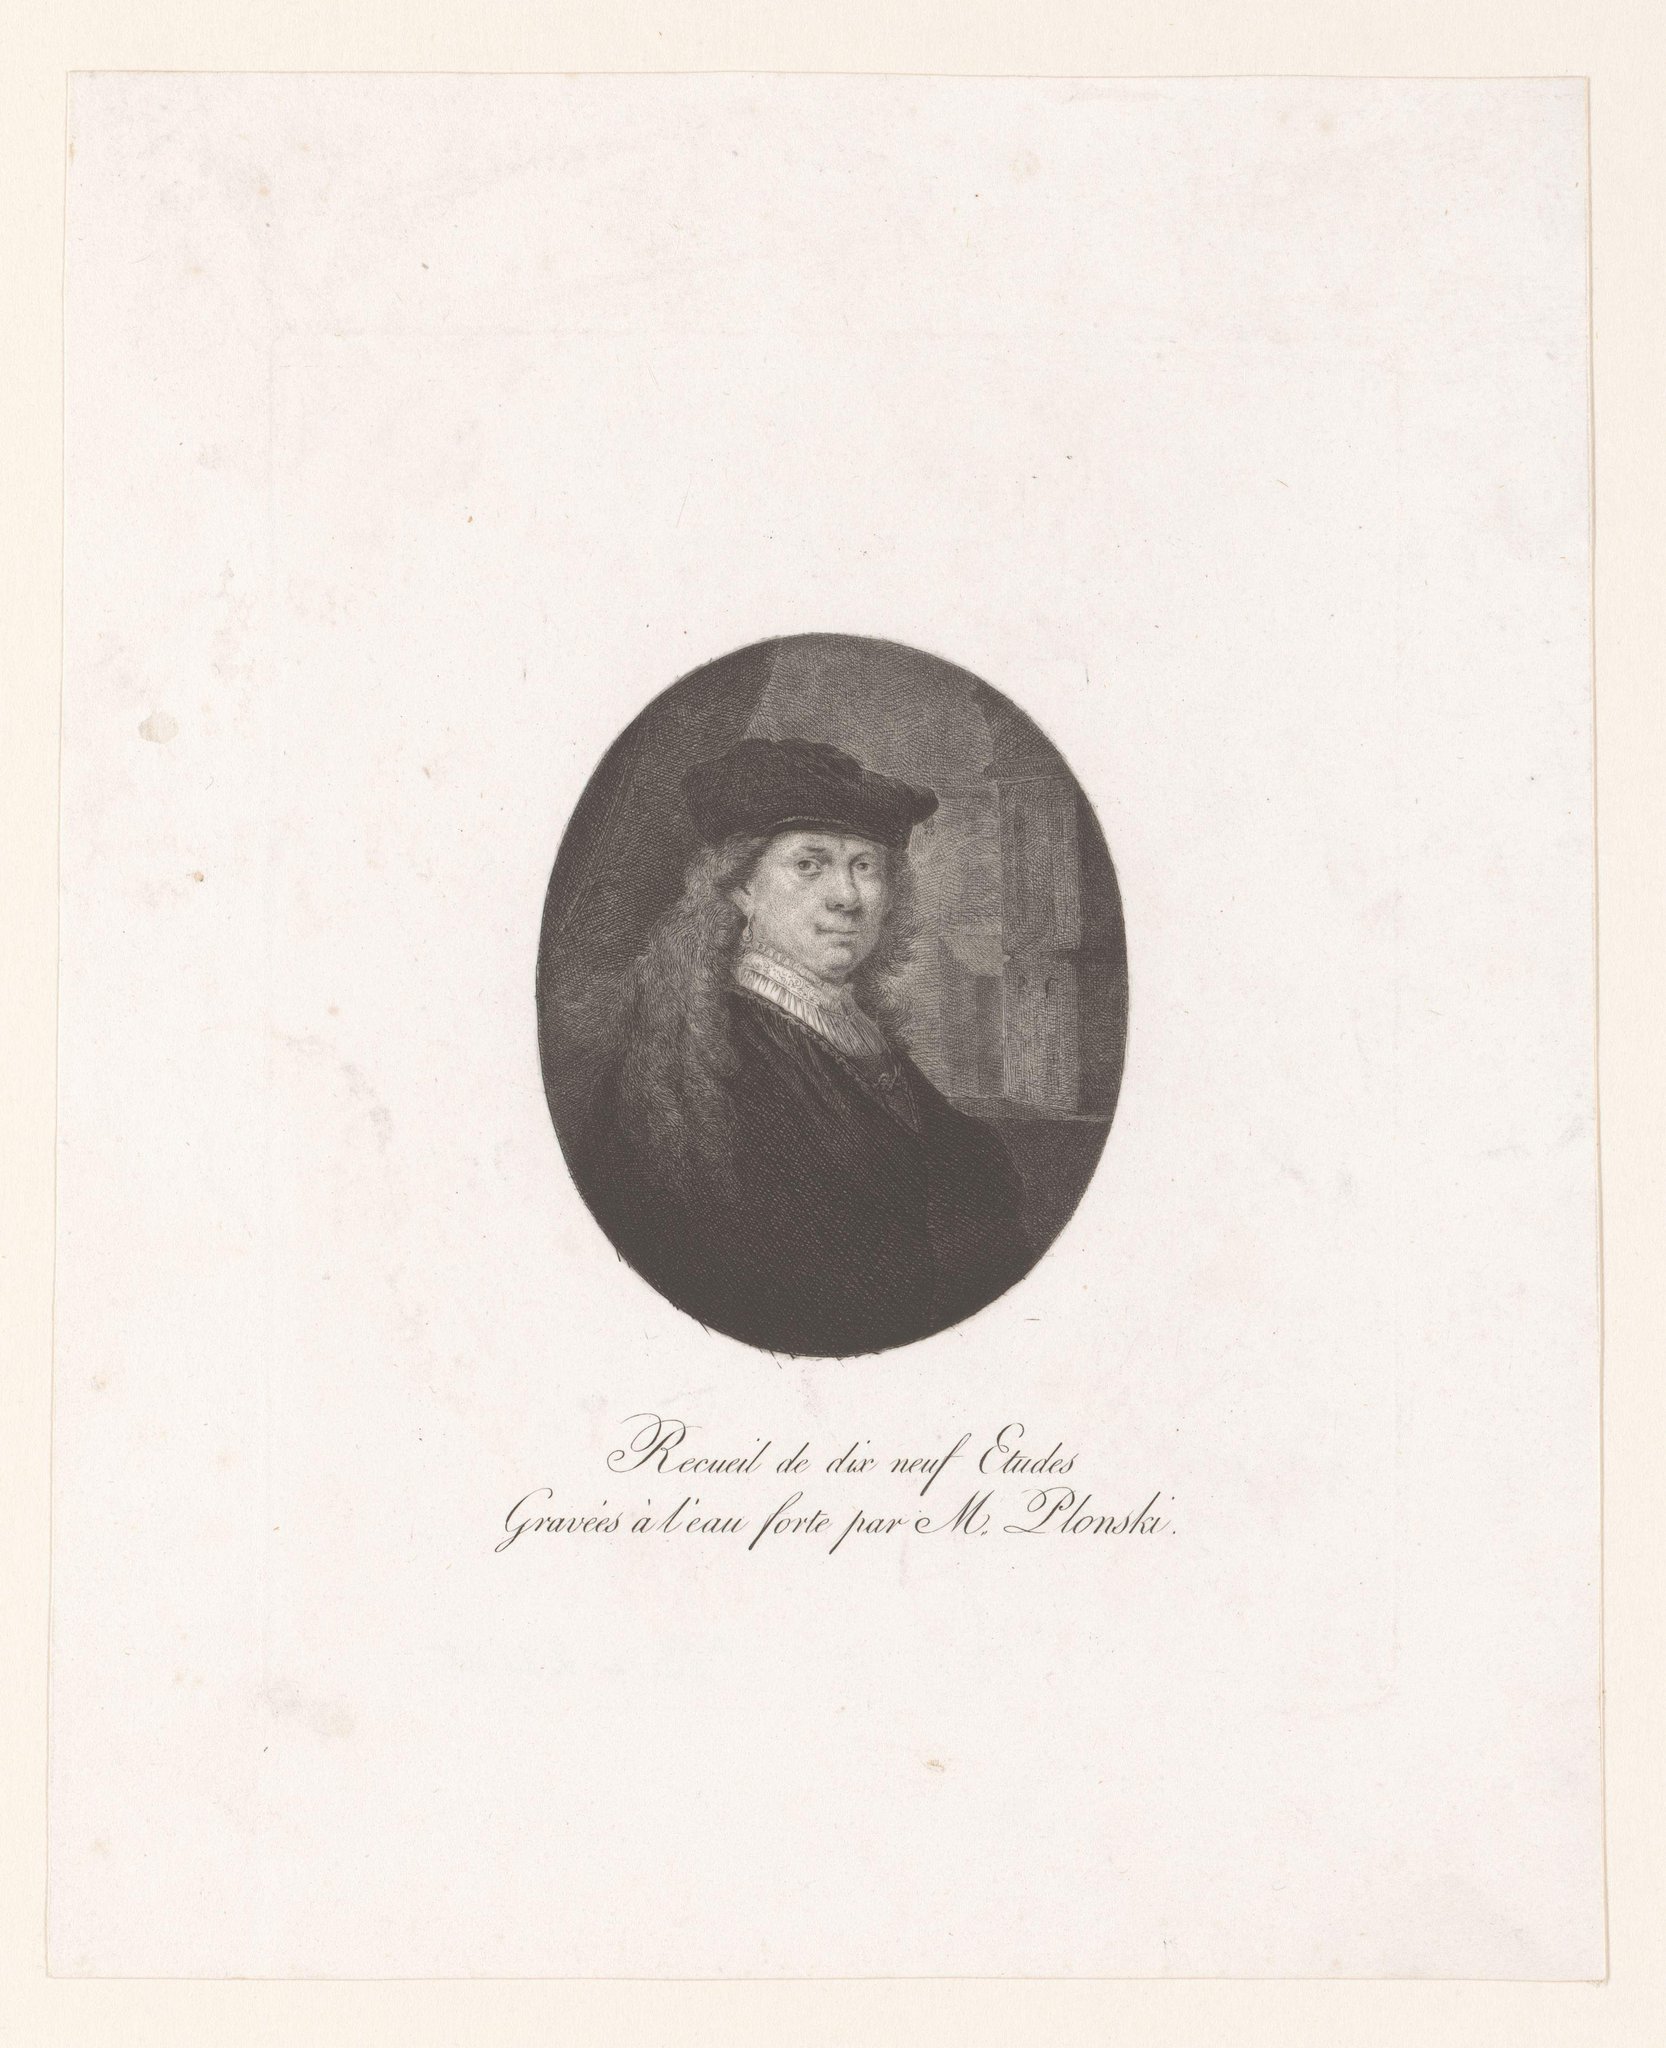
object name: print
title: Portret van Rembrandt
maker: michał płoński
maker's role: print maker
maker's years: 1778-1812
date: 1788-1812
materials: paper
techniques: etching, intaglio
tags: leiden, painter, print maker, draughtsman, rembrandt van rijn, portrait, self-portrait of painter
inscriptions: collector's mark: Lugt 2228